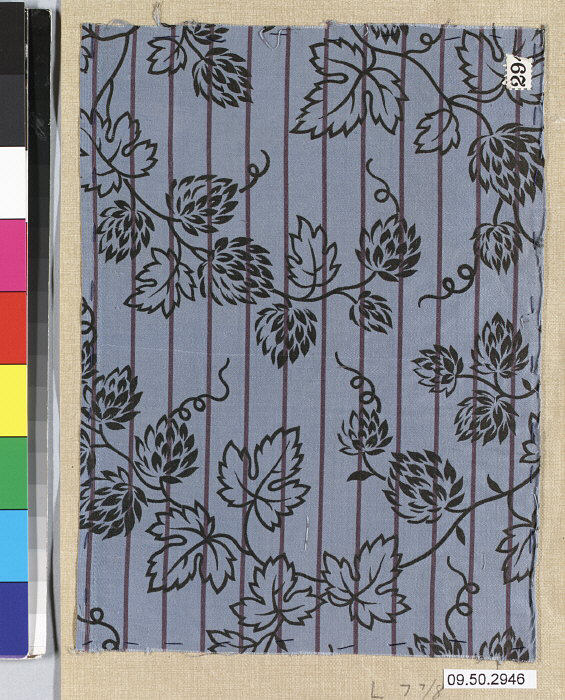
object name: piece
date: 1801-1900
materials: cotton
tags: leaves